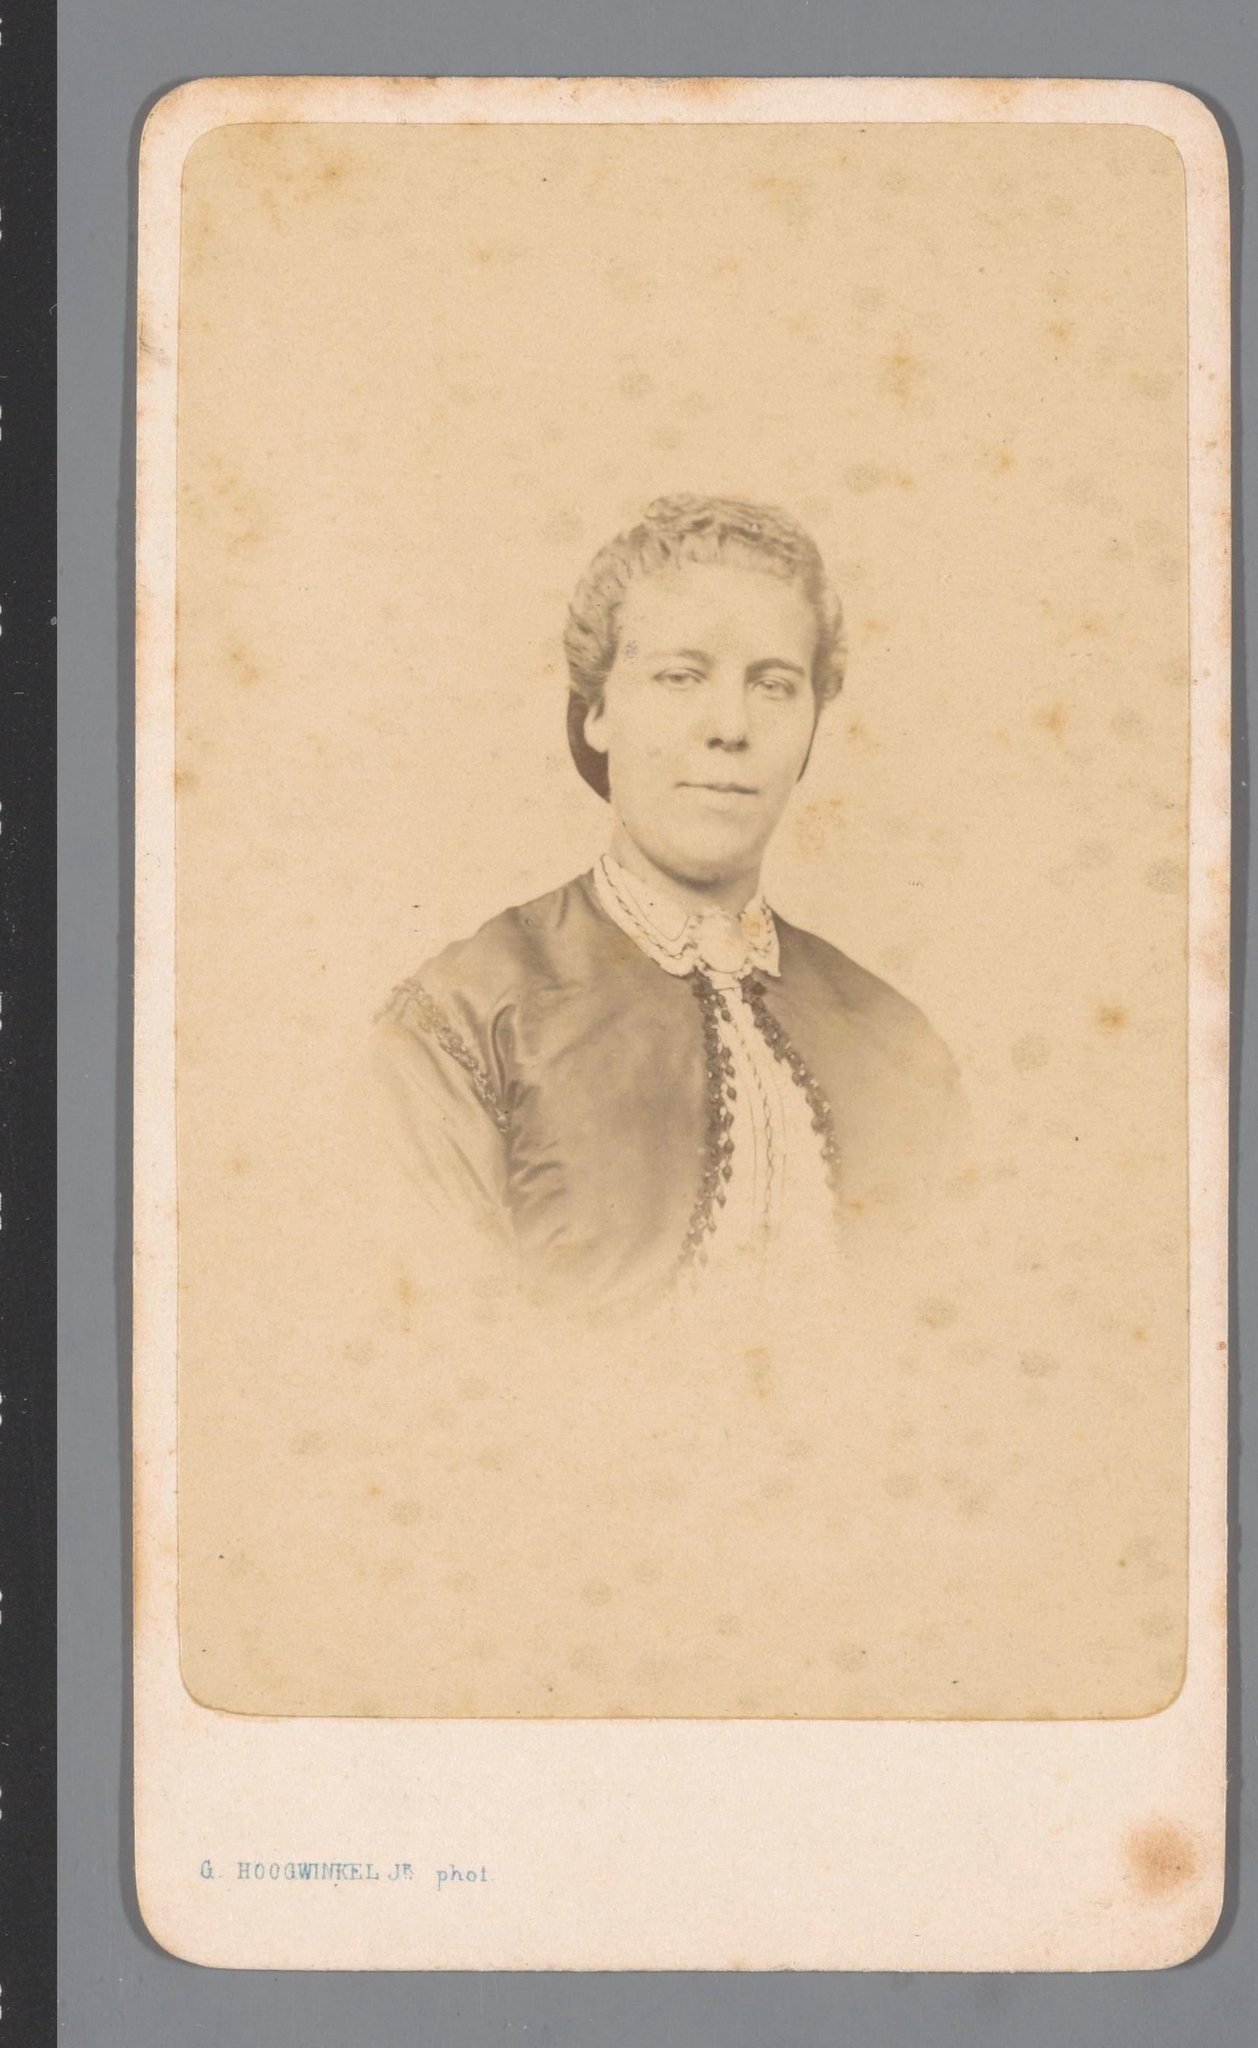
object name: photograph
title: Portret van een vrouw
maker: gerrit hoogwinkel jr.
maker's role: fotograaf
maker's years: 1837-1890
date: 1865-1870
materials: cardboard, paper, photographic support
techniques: albumen print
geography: rotterdam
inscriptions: signature and address: ‘G. Hoogwinkel jr/Photographe/Rotterdam/56, Hoogstraat’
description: Buste van een vrouw. Het lijfje van haar japon heeft bolero-model.